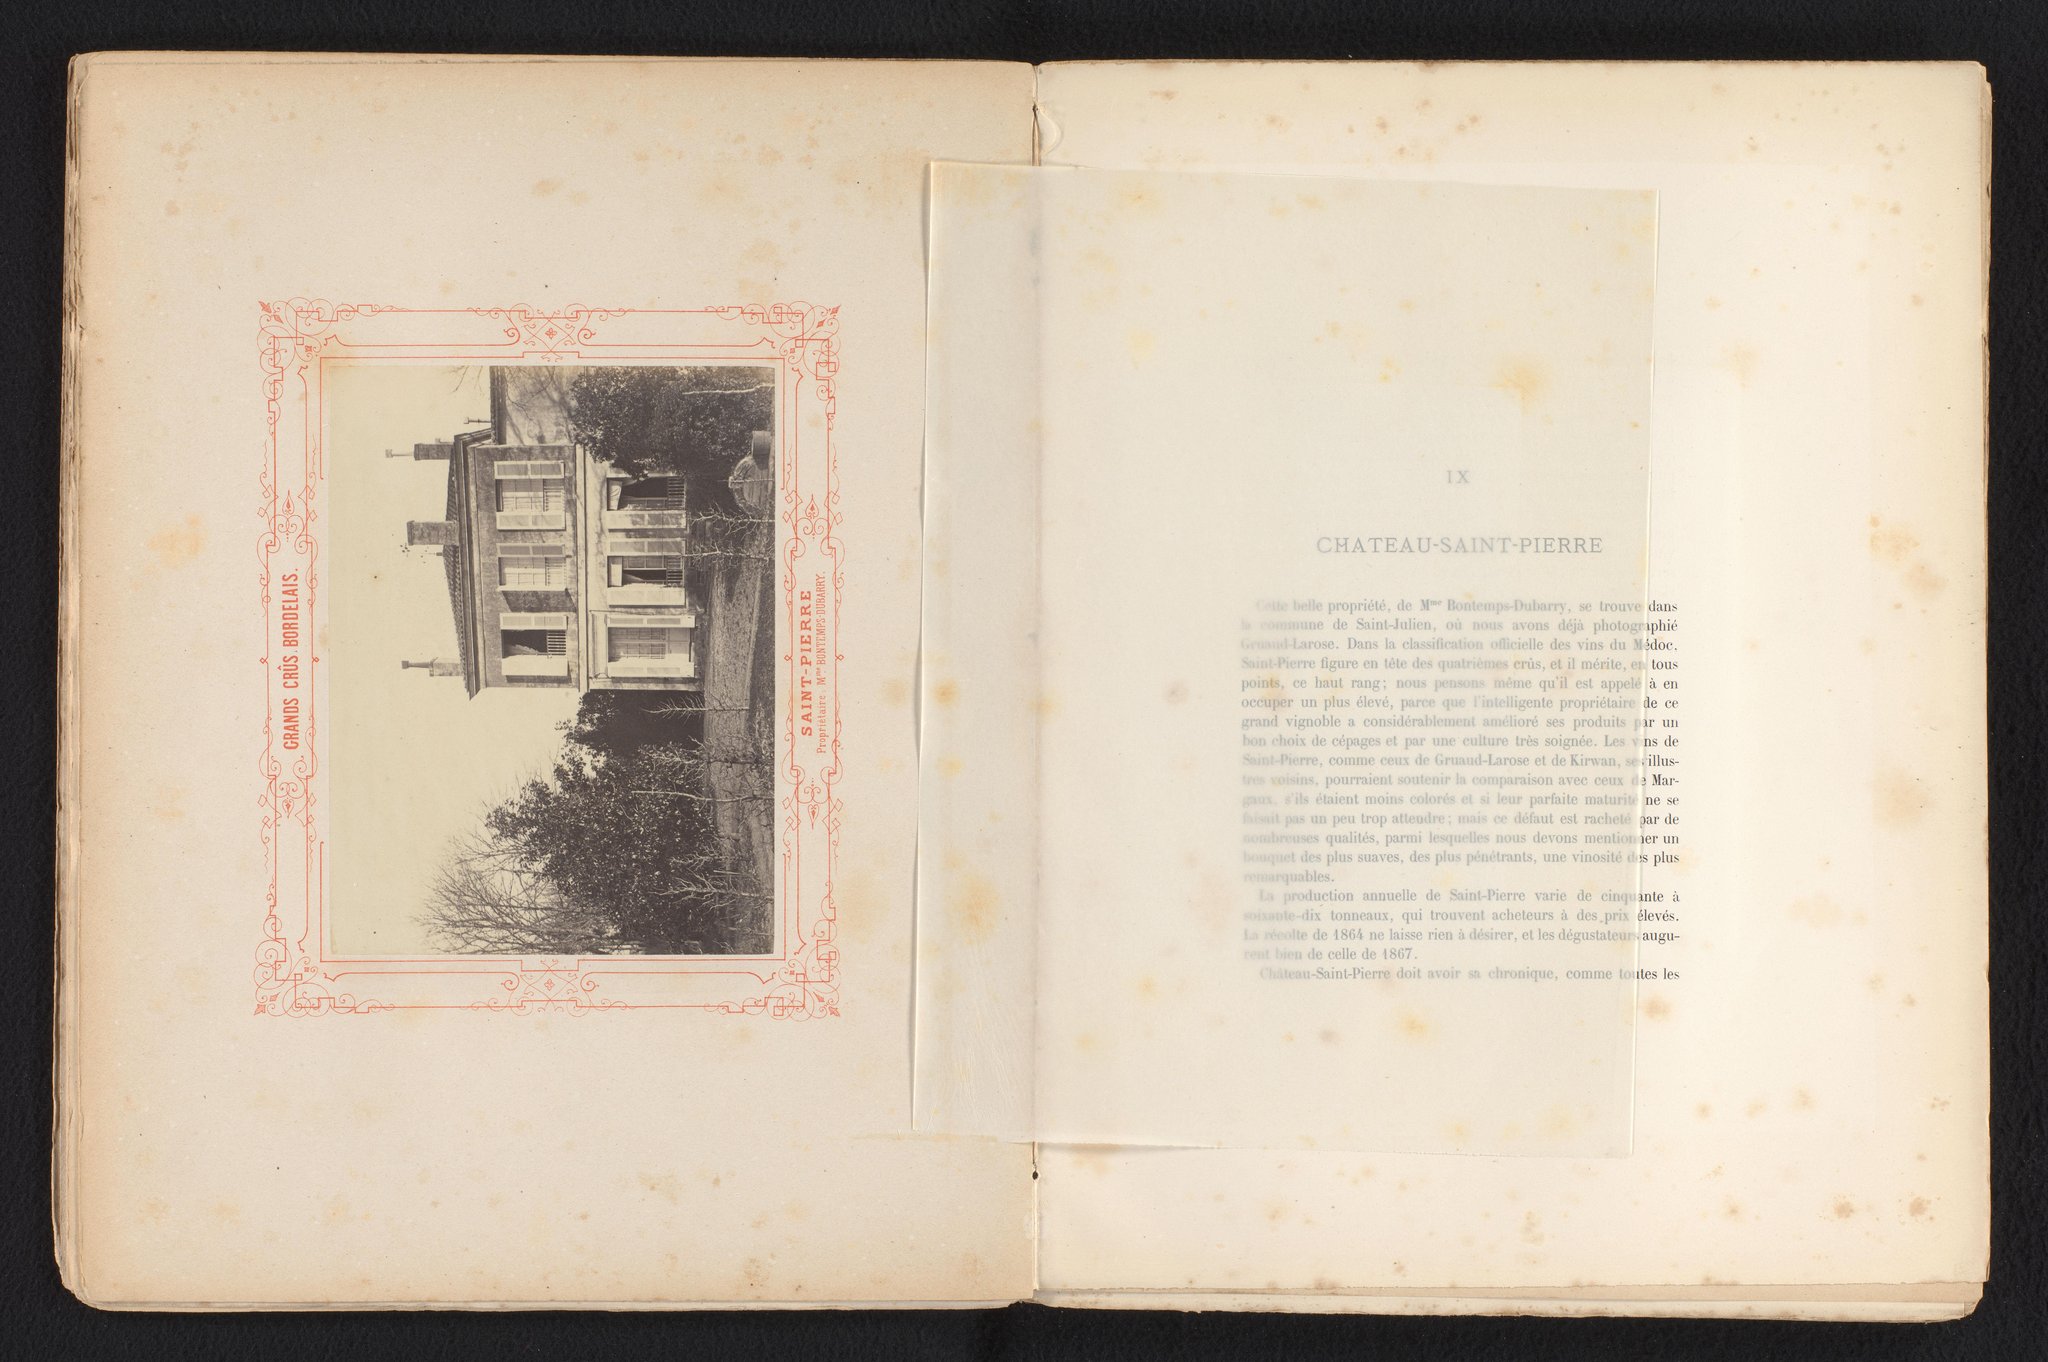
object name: photograph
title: Grands crûs Bordelais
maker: alfred danflou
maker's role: fotograaf, schrijver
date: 1862-1867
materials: paper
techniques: albumen print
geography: saint-julien-beychevelle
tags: castle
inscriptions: inscription: ‘Propriétaire: Mme. BONTEMPS-DUBARRY.’